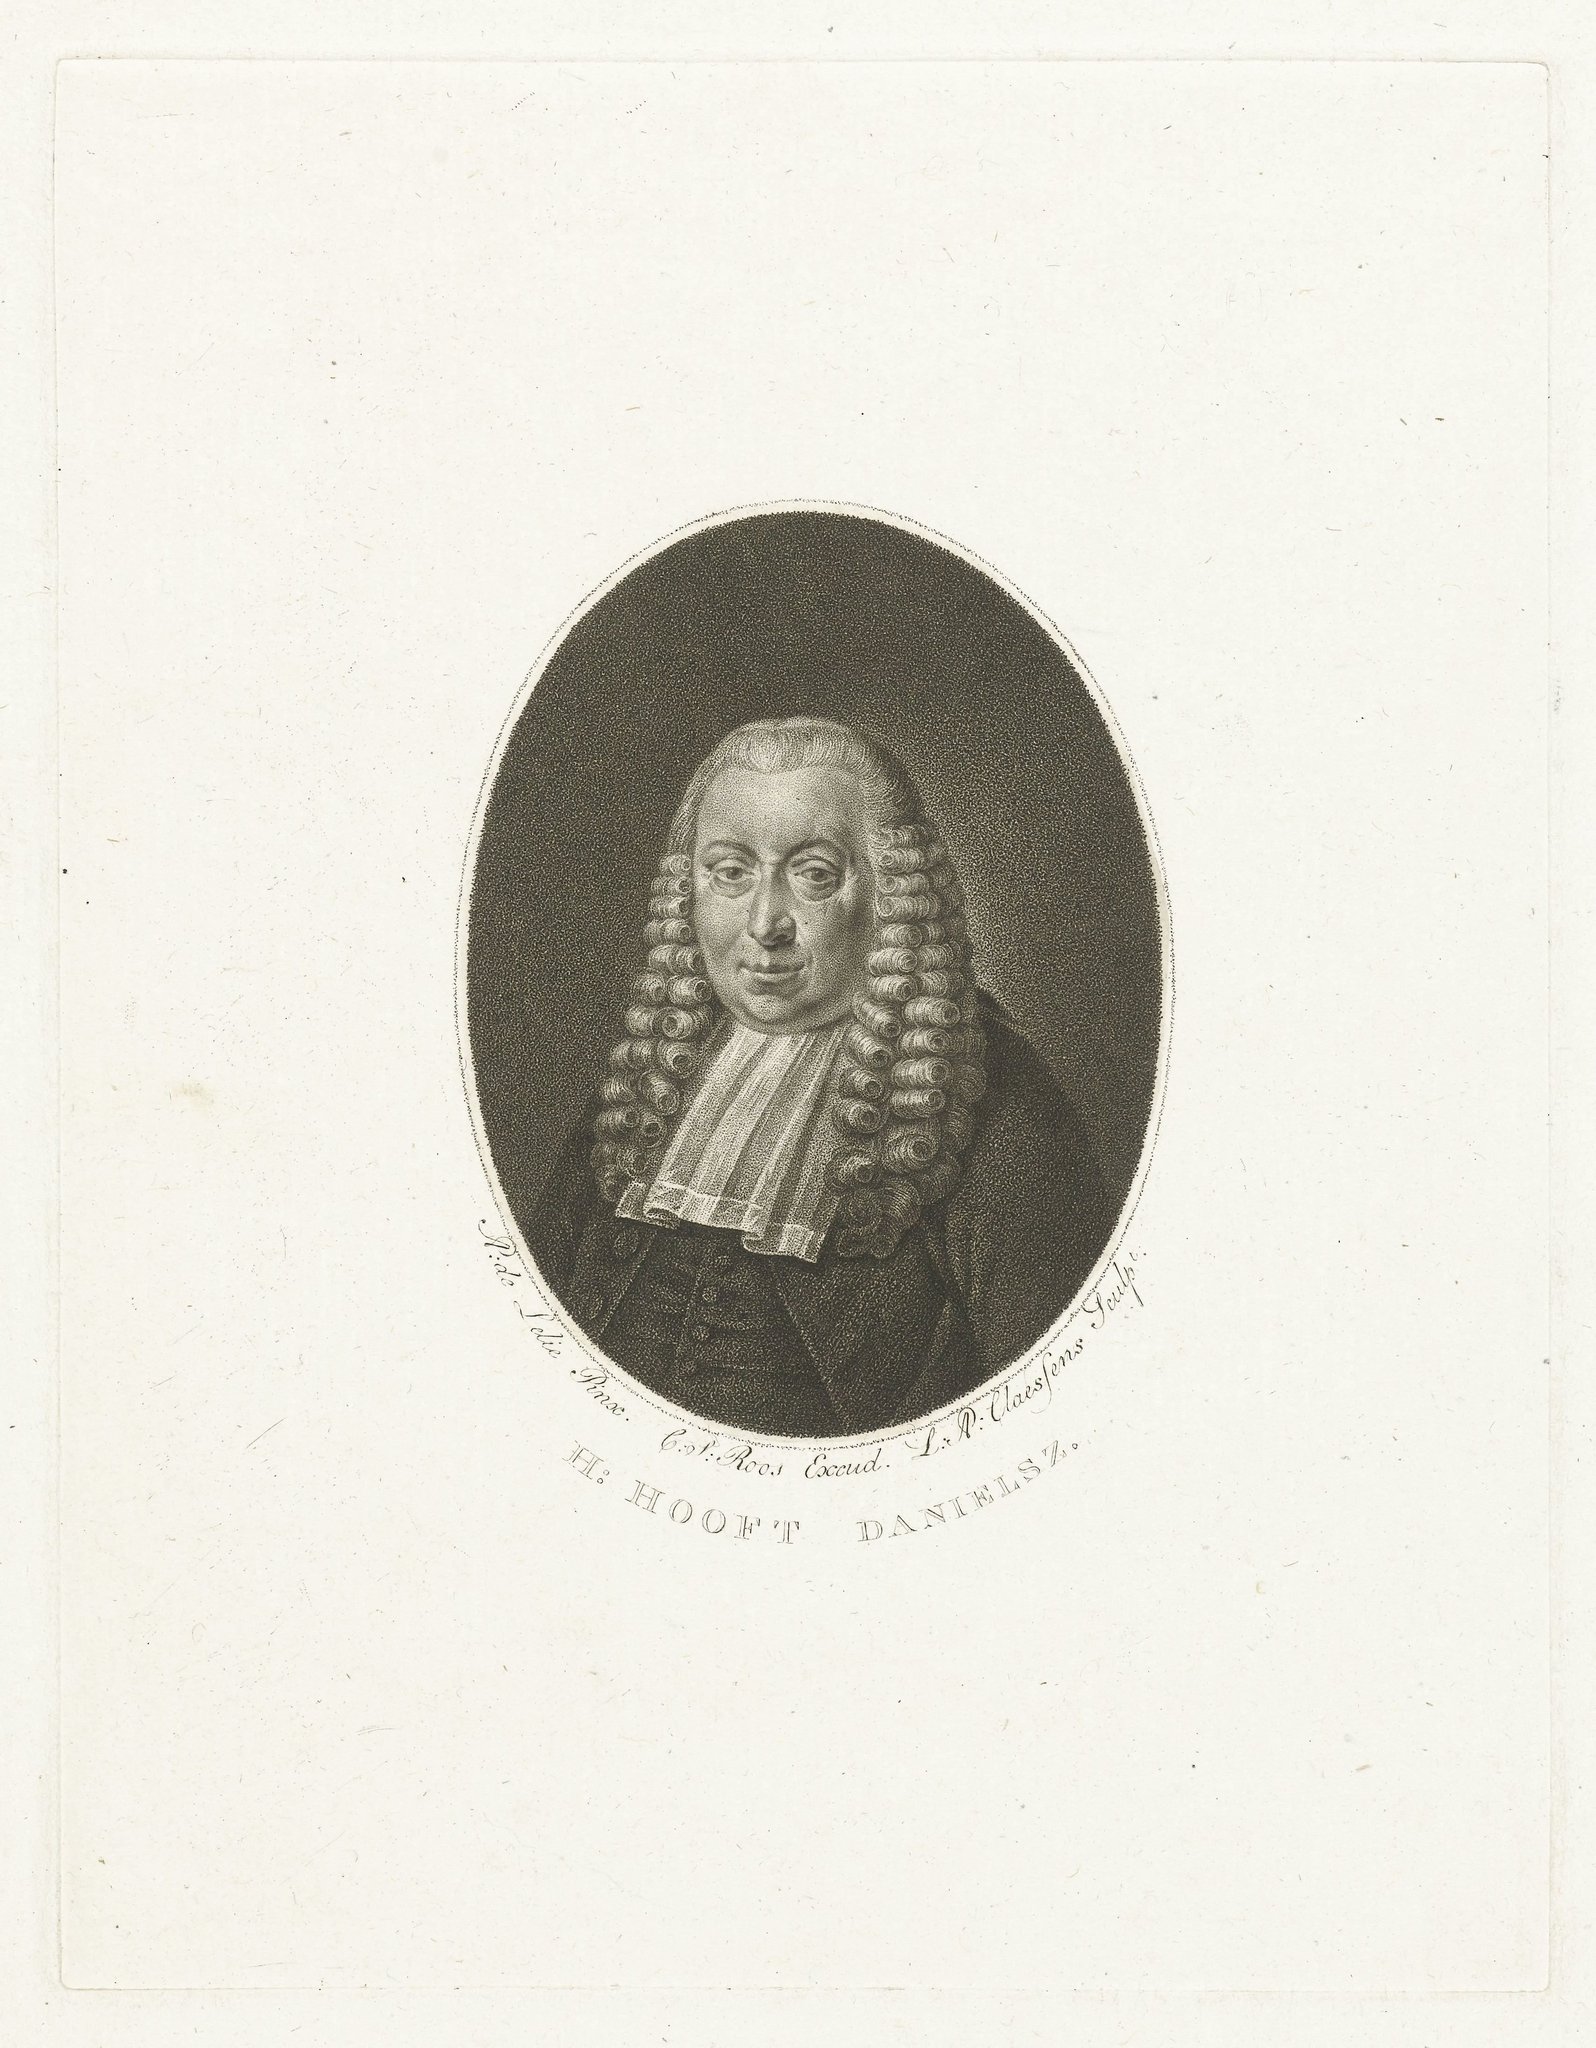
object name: print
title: Portret van de Amsterdamse burgermeester Hendrik Danielsz. Hooft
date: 1792-1808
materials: paper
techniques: engraving, etching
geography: amsterdam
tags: amsterdam, mayor, hendrik danielsz. hooft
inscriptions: collector's mark: Lugt 2228